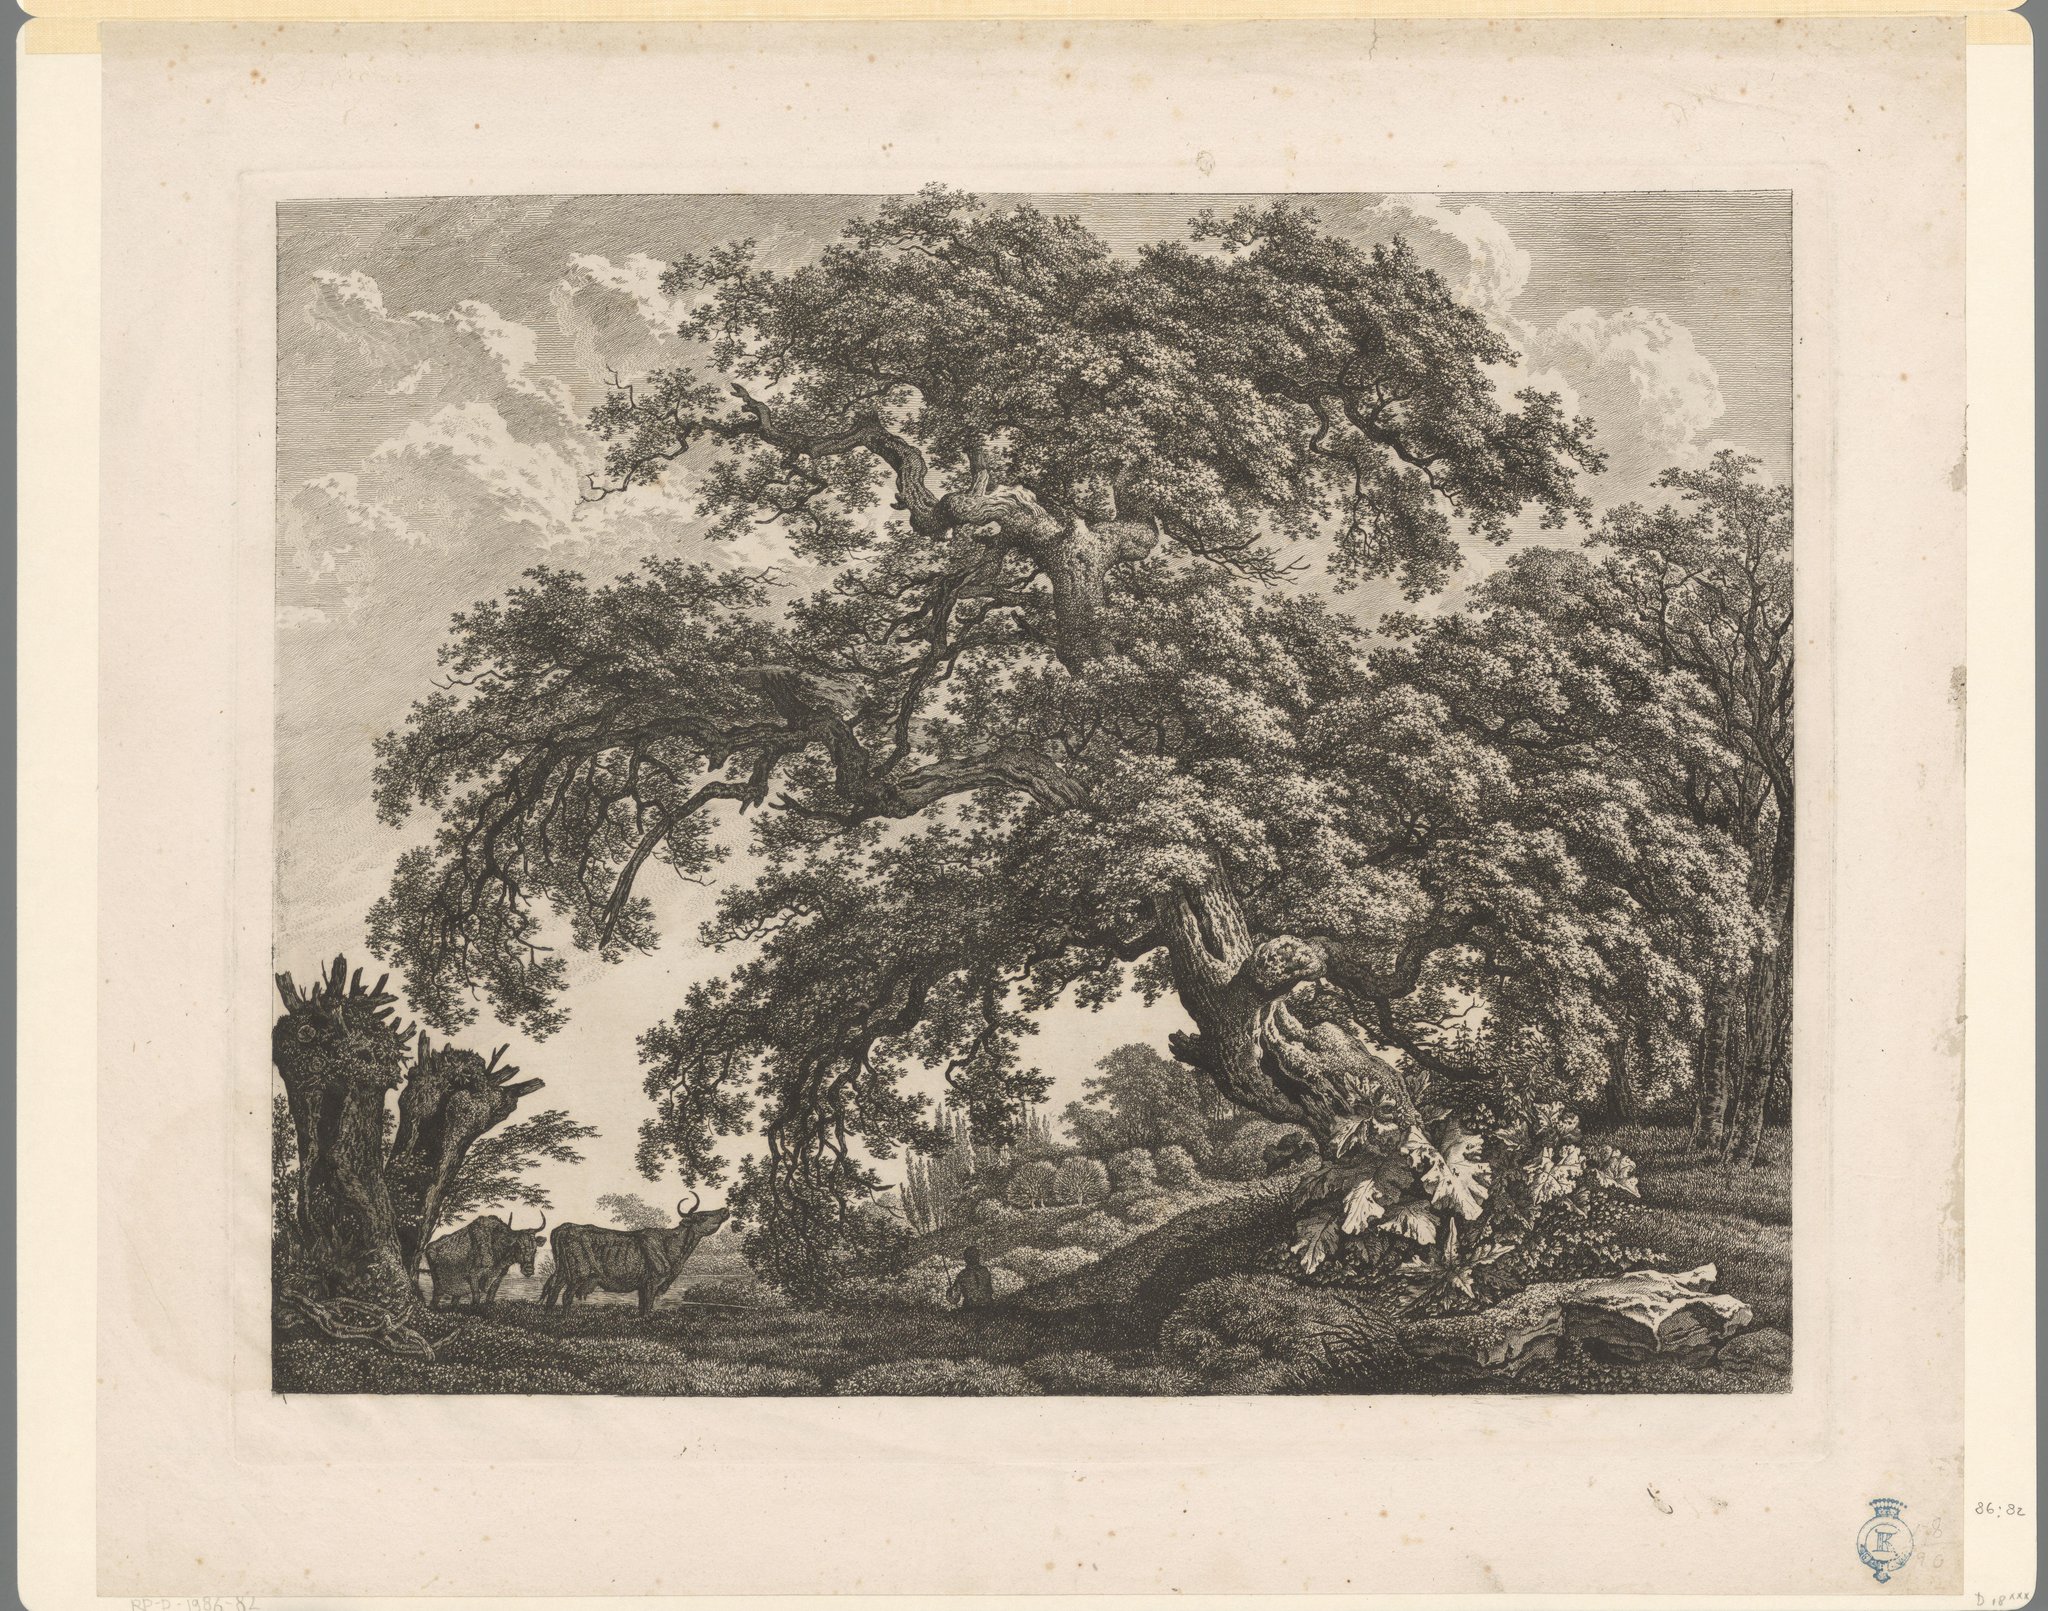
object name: print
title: Landschap met twee koeien bij een grote eik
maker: carl wilhelm kolbe (i)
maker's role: print maker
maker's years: 1757-1835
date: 1767-1835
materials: paper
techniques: etching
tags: cattle, lower plants, trees: oak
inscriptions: collector's mark: Lugt 2228, collector's mark, collector's mark: Lugt 2760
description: Onderaan de grote eik staat een volgroeide grote klit.